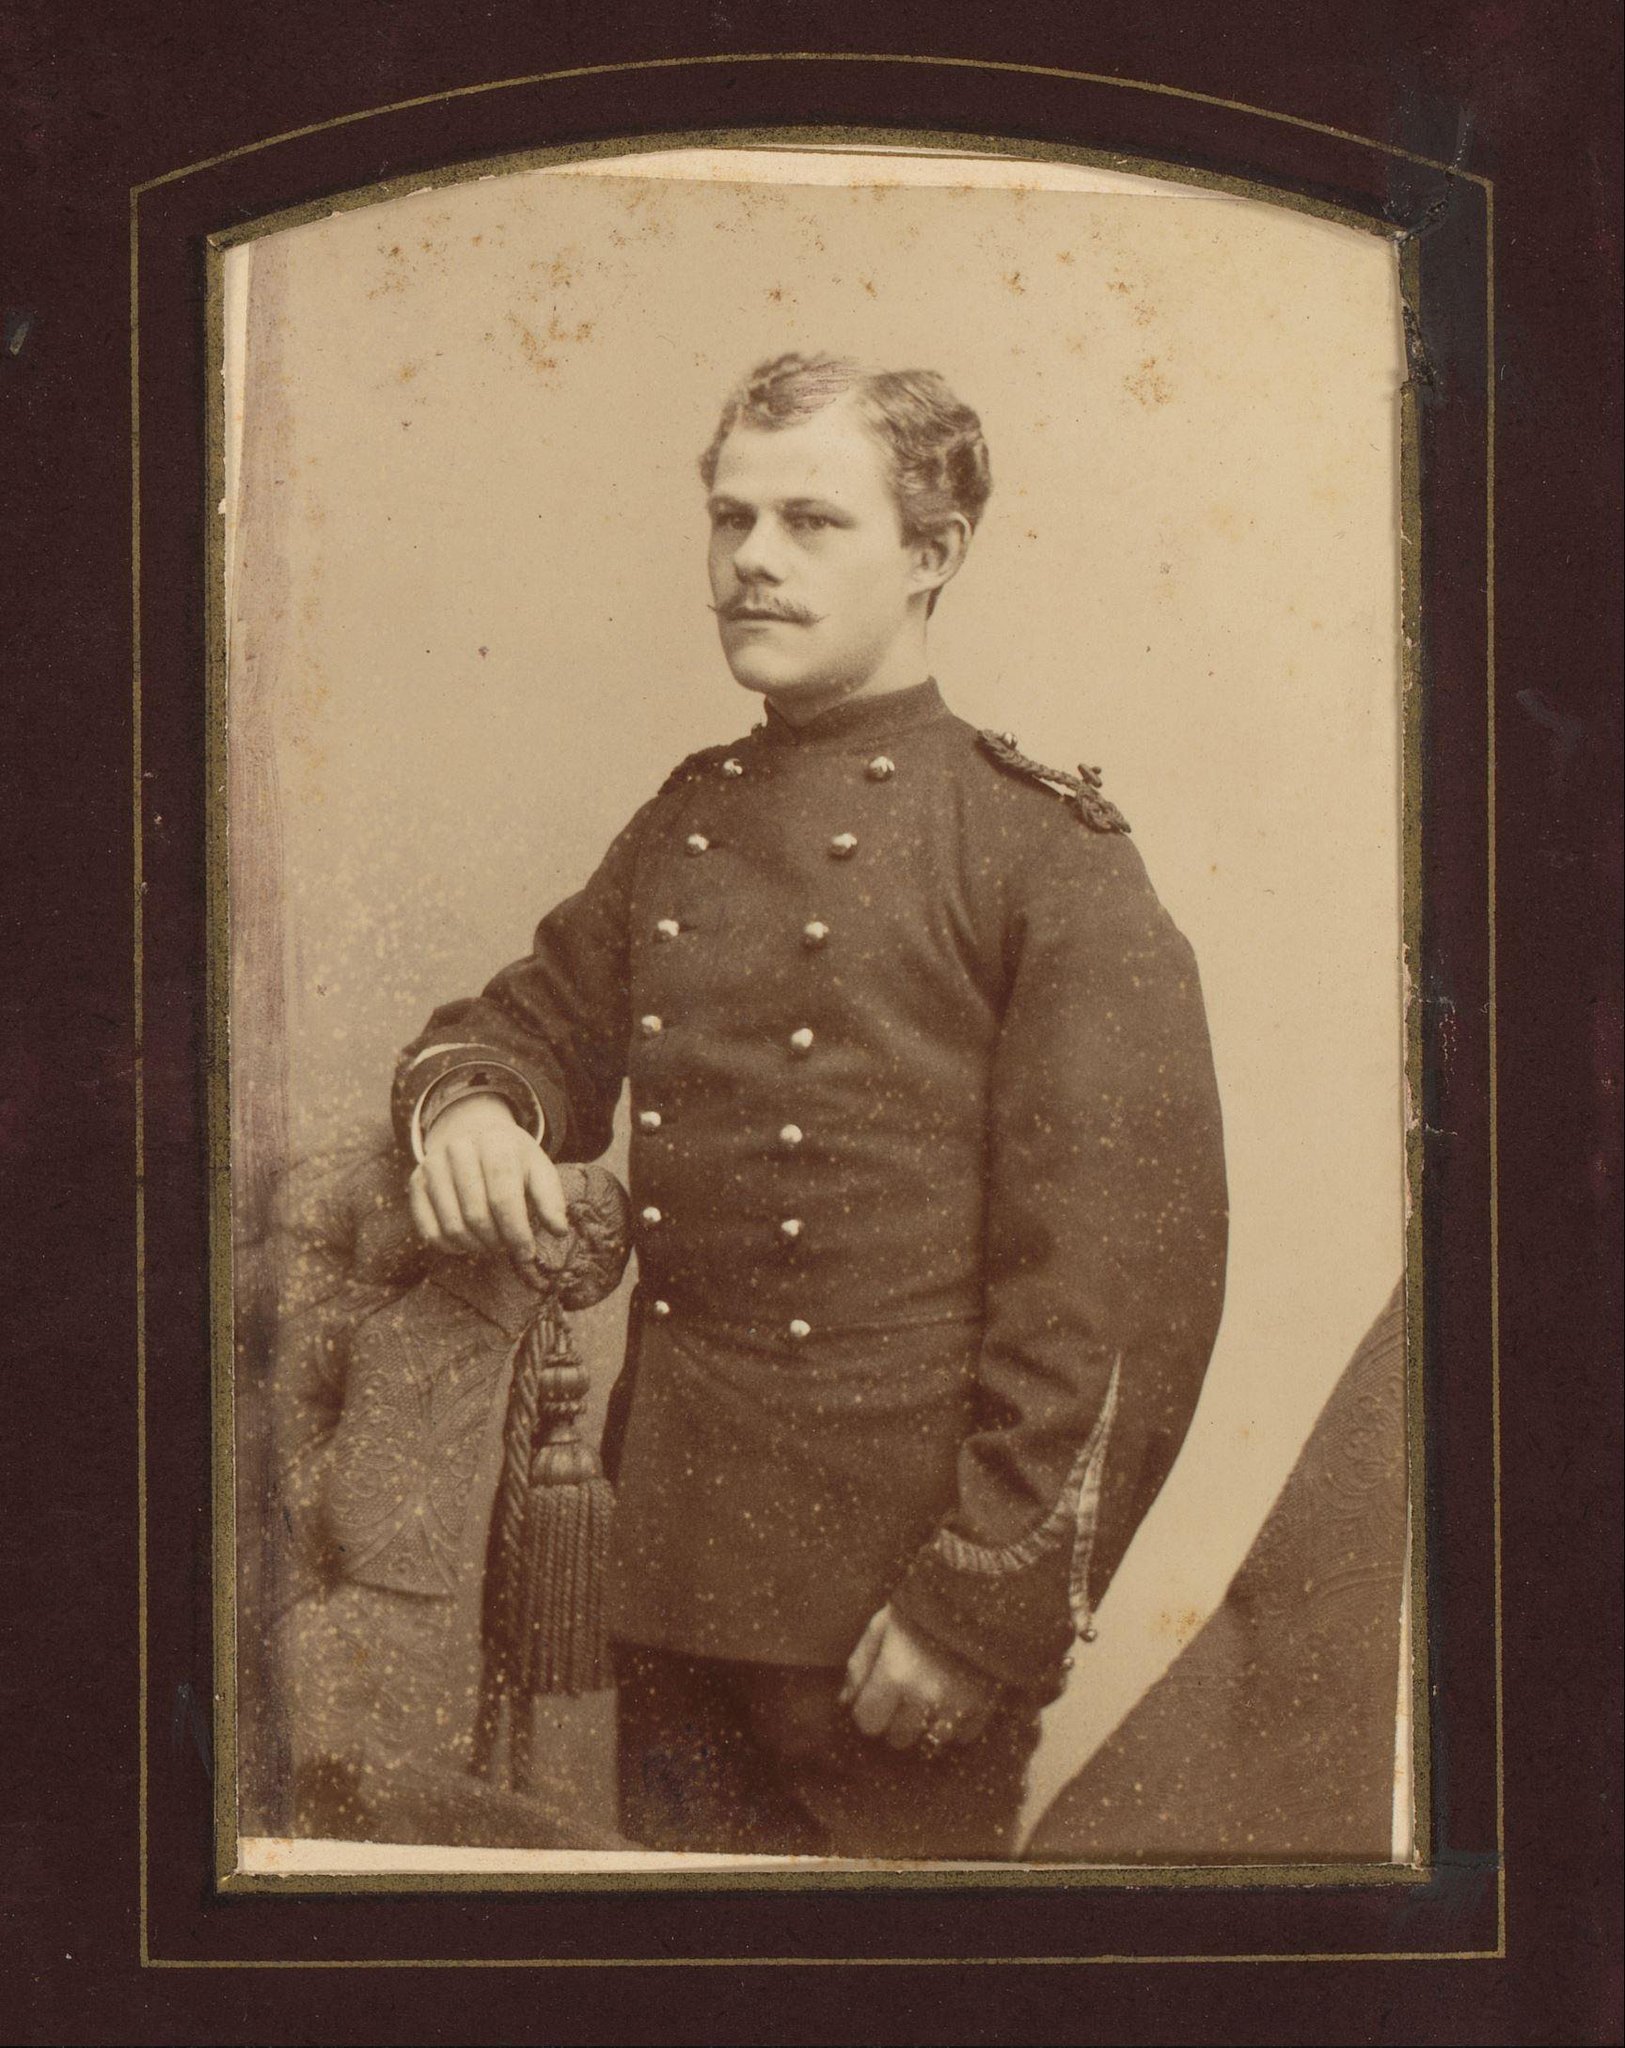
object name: album leaf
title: Portret van een staande jonge man, leunend op een stoel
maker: robert ziegler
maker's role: fotograaf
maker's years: 1863-1931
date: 1884-1905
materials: cardboard, photographic support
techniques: albumen print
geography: harderwijk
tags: historical persons, youth, adolescent, chair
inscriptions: inscription: ‘CABINET-PORTRAIT/ von/ R. ZIEGLER & Co./ HARDERWIJK.’